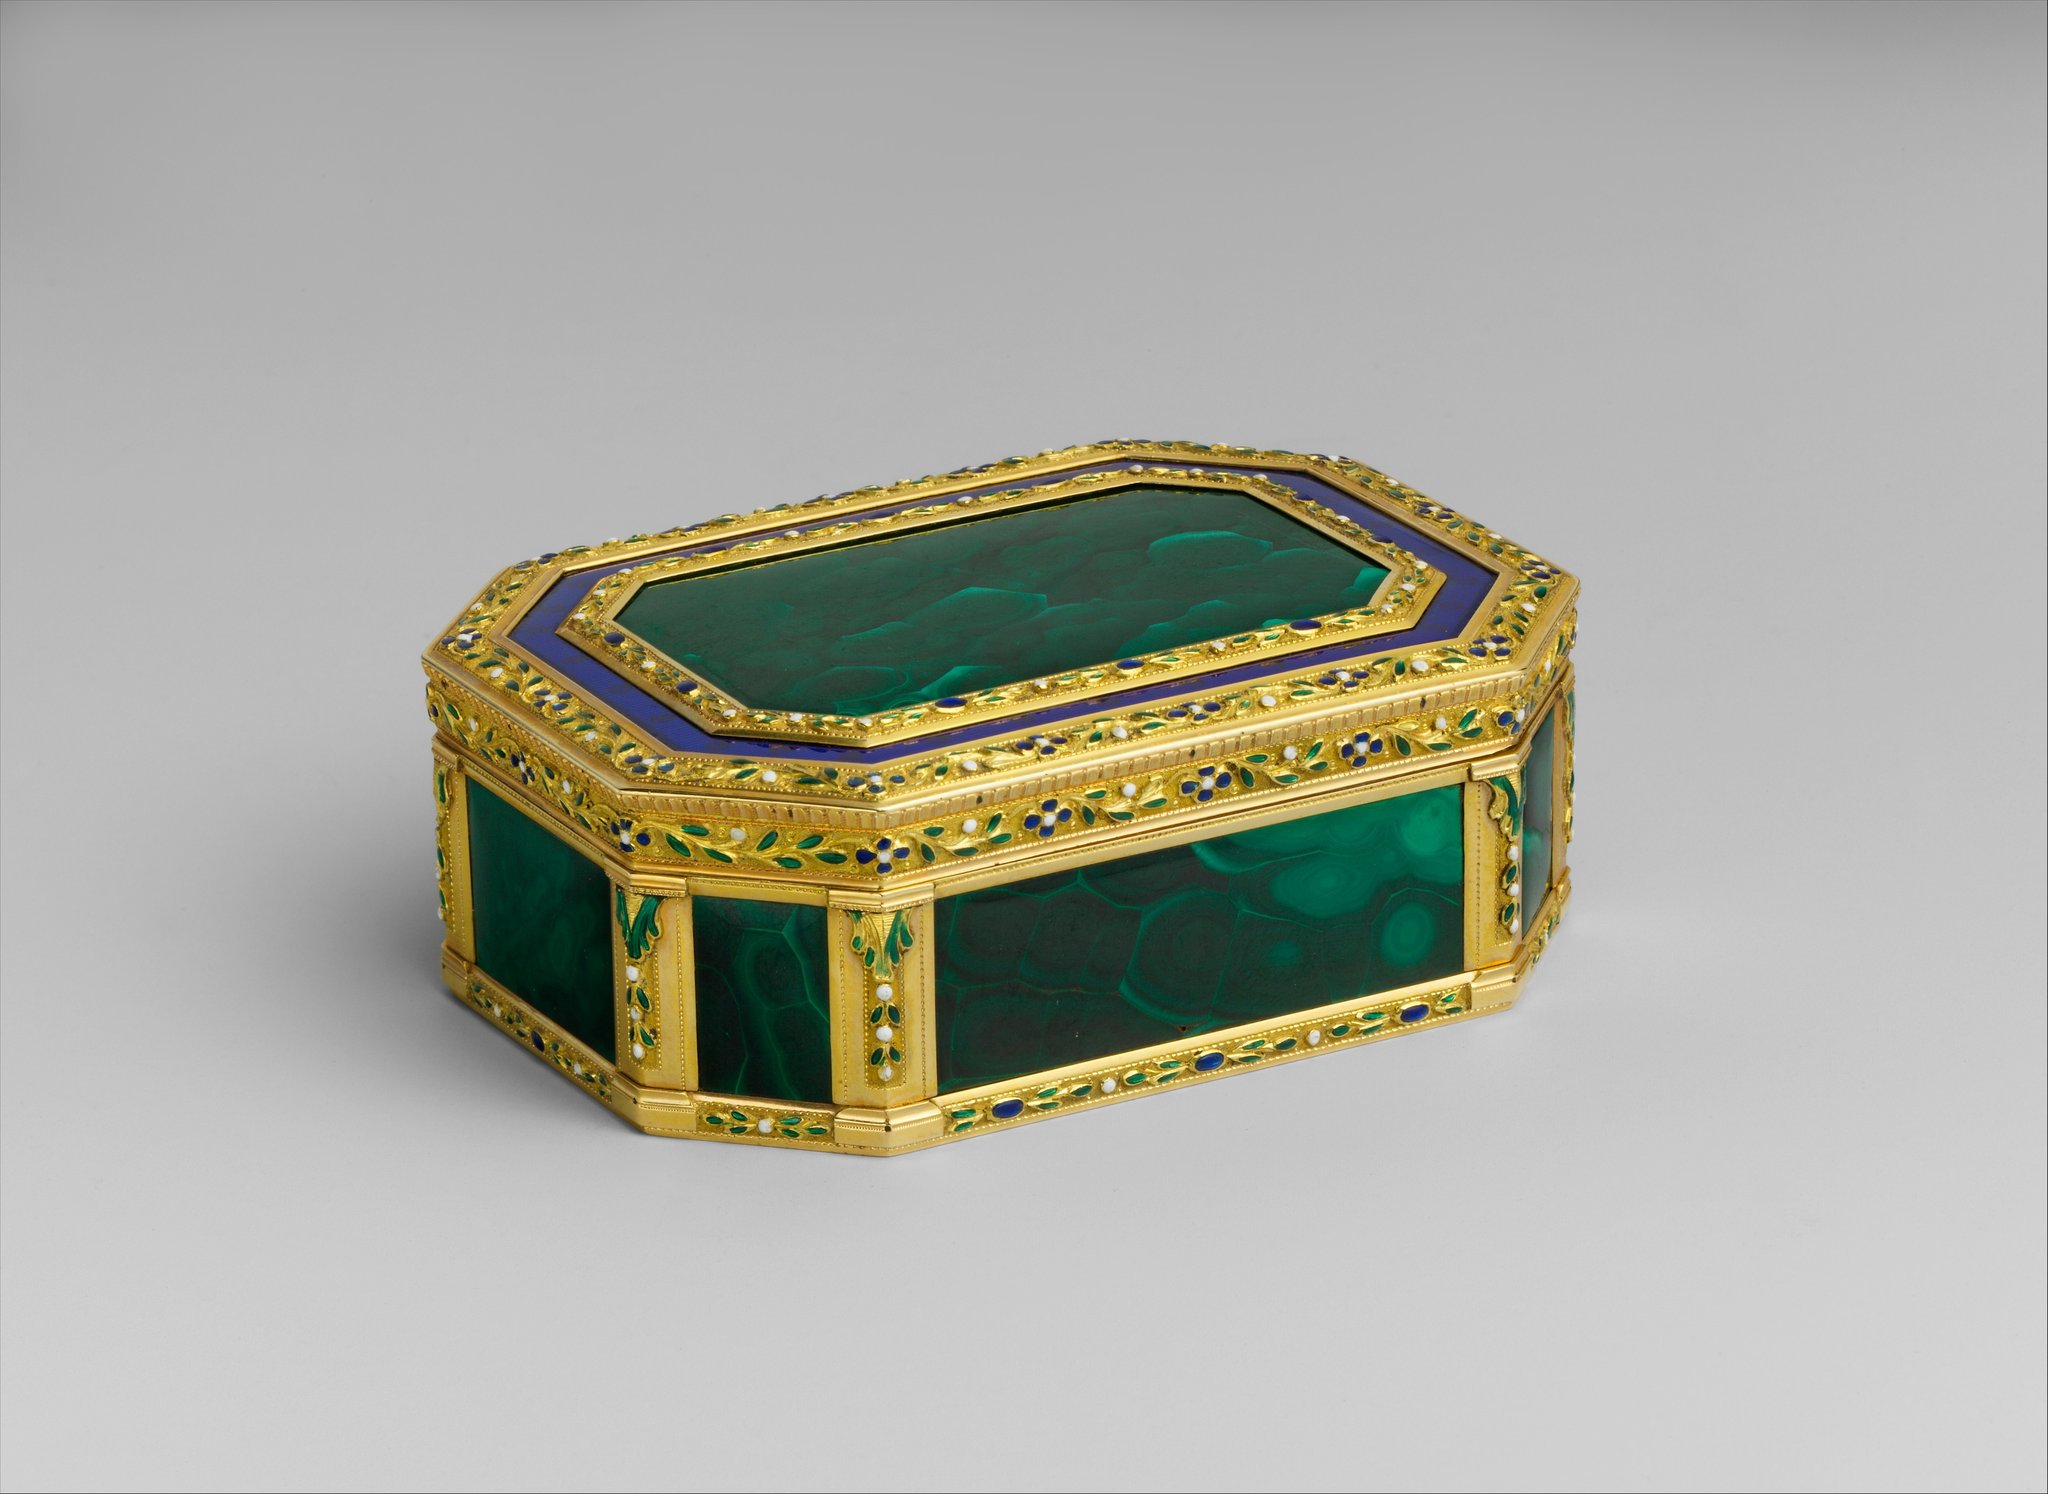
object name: snuffbox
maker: adrien jean maximilien vachette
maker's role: maker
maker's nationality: french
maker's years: 1753-1839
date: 1782-1783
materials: enamel, gold